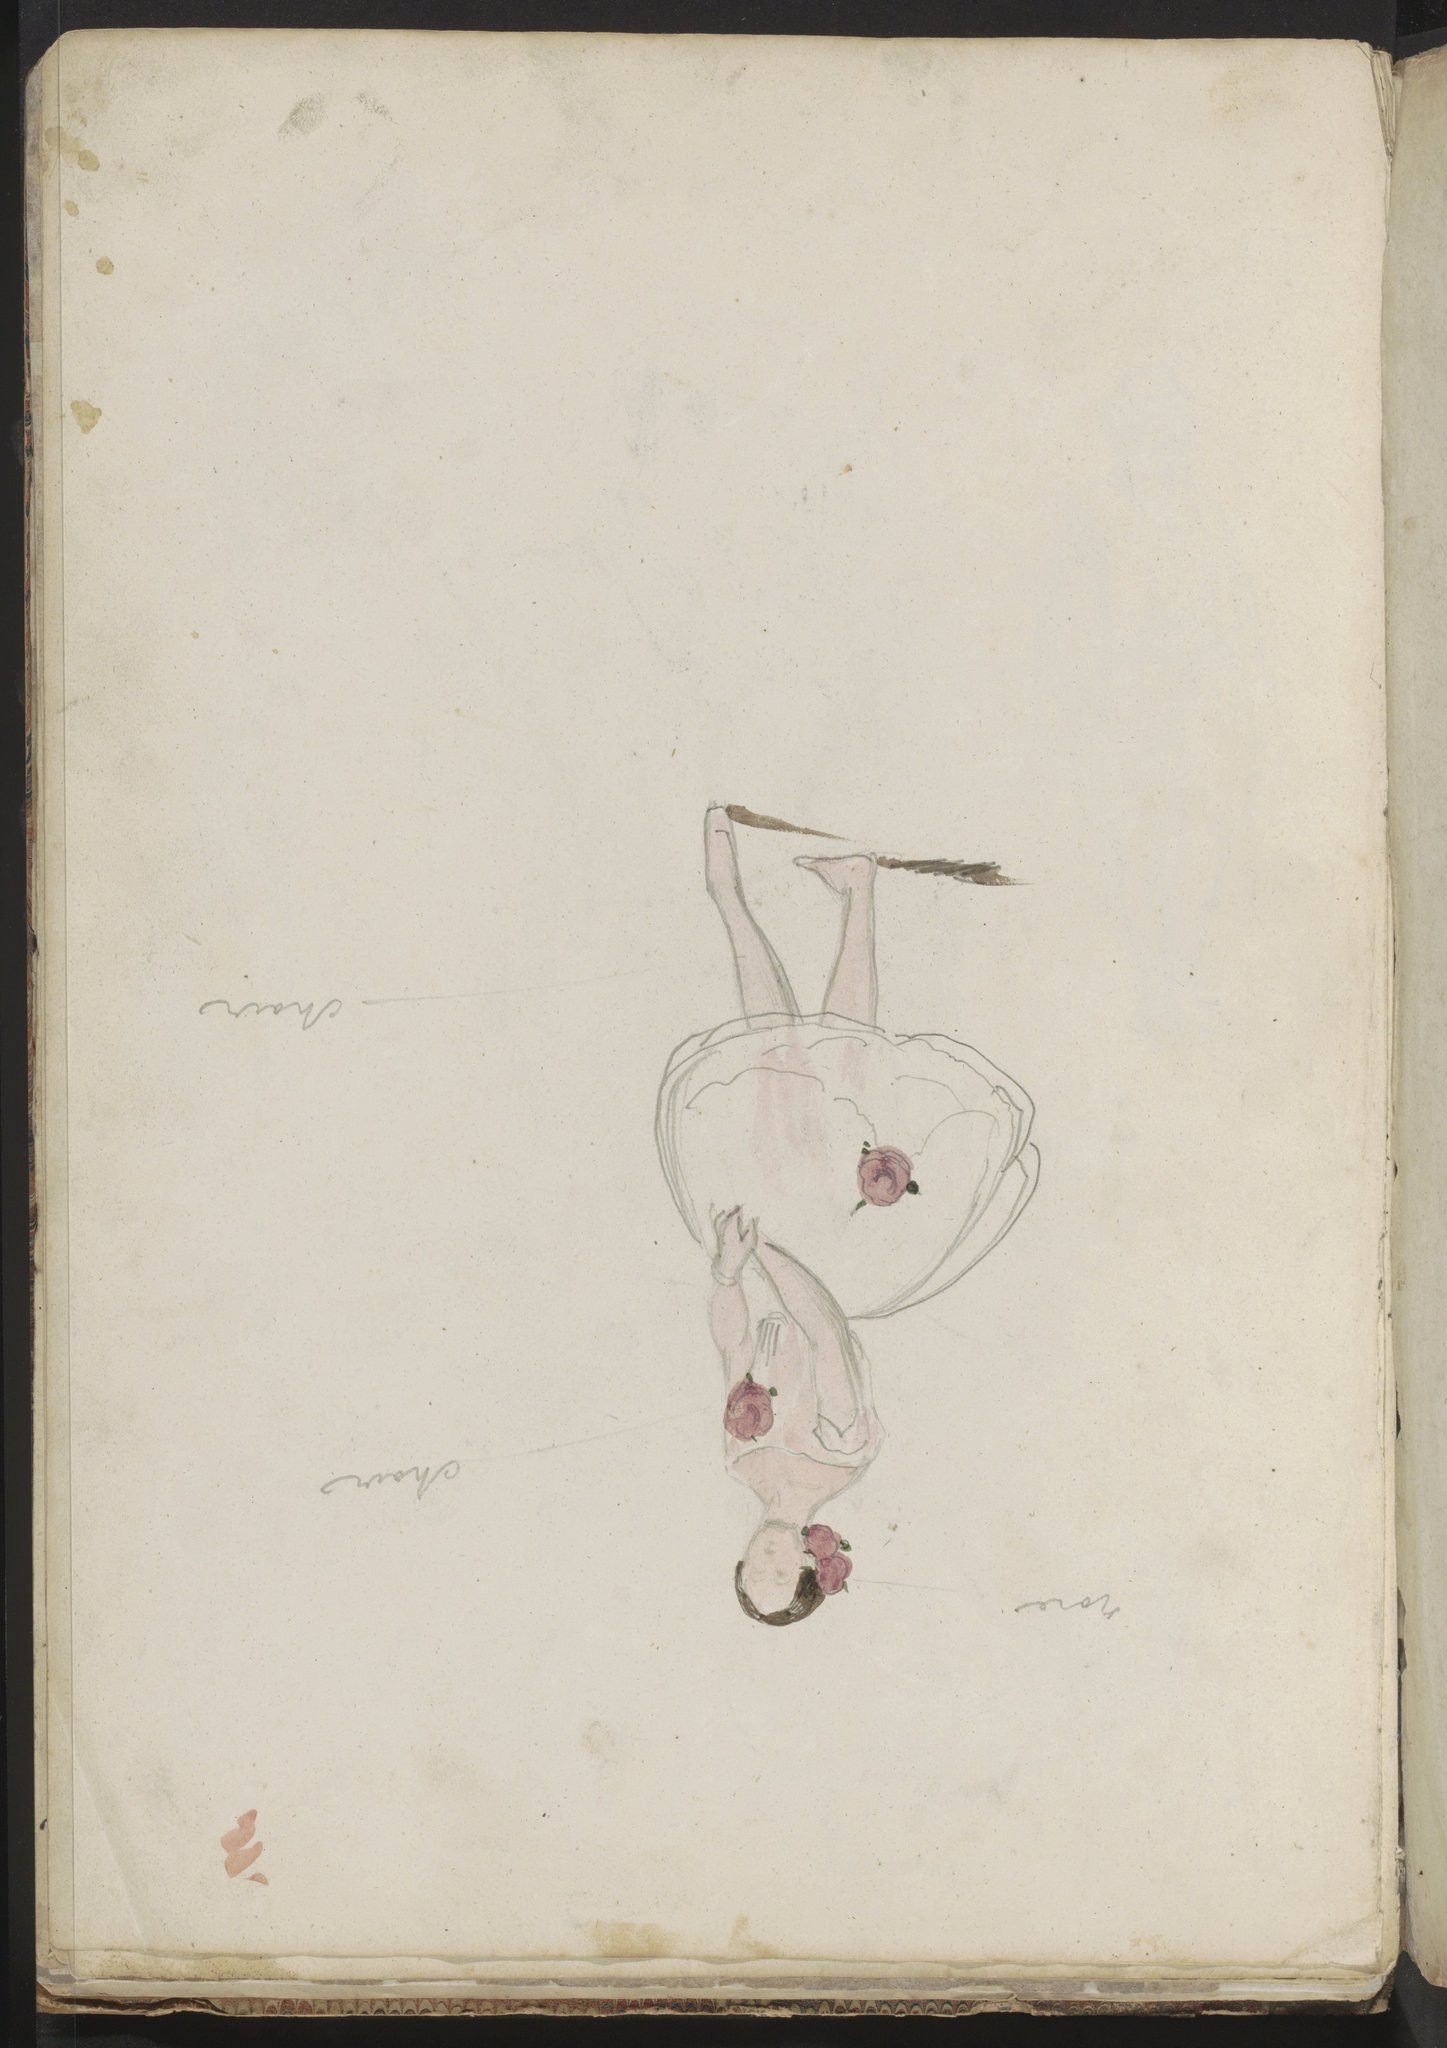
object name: sketchbook leaf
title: Ballerina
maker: johannes huybertus van hove bzn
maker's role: print maker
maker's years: 1827-1881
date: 1837-1881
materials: paper, pencil, watercolor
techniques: brush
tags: female dancer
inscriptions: kleurnotitie, handgeschreven in potlood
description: Blad 32 verso uit een schetsboek met 33 bladen en 10 losse tekeningen.